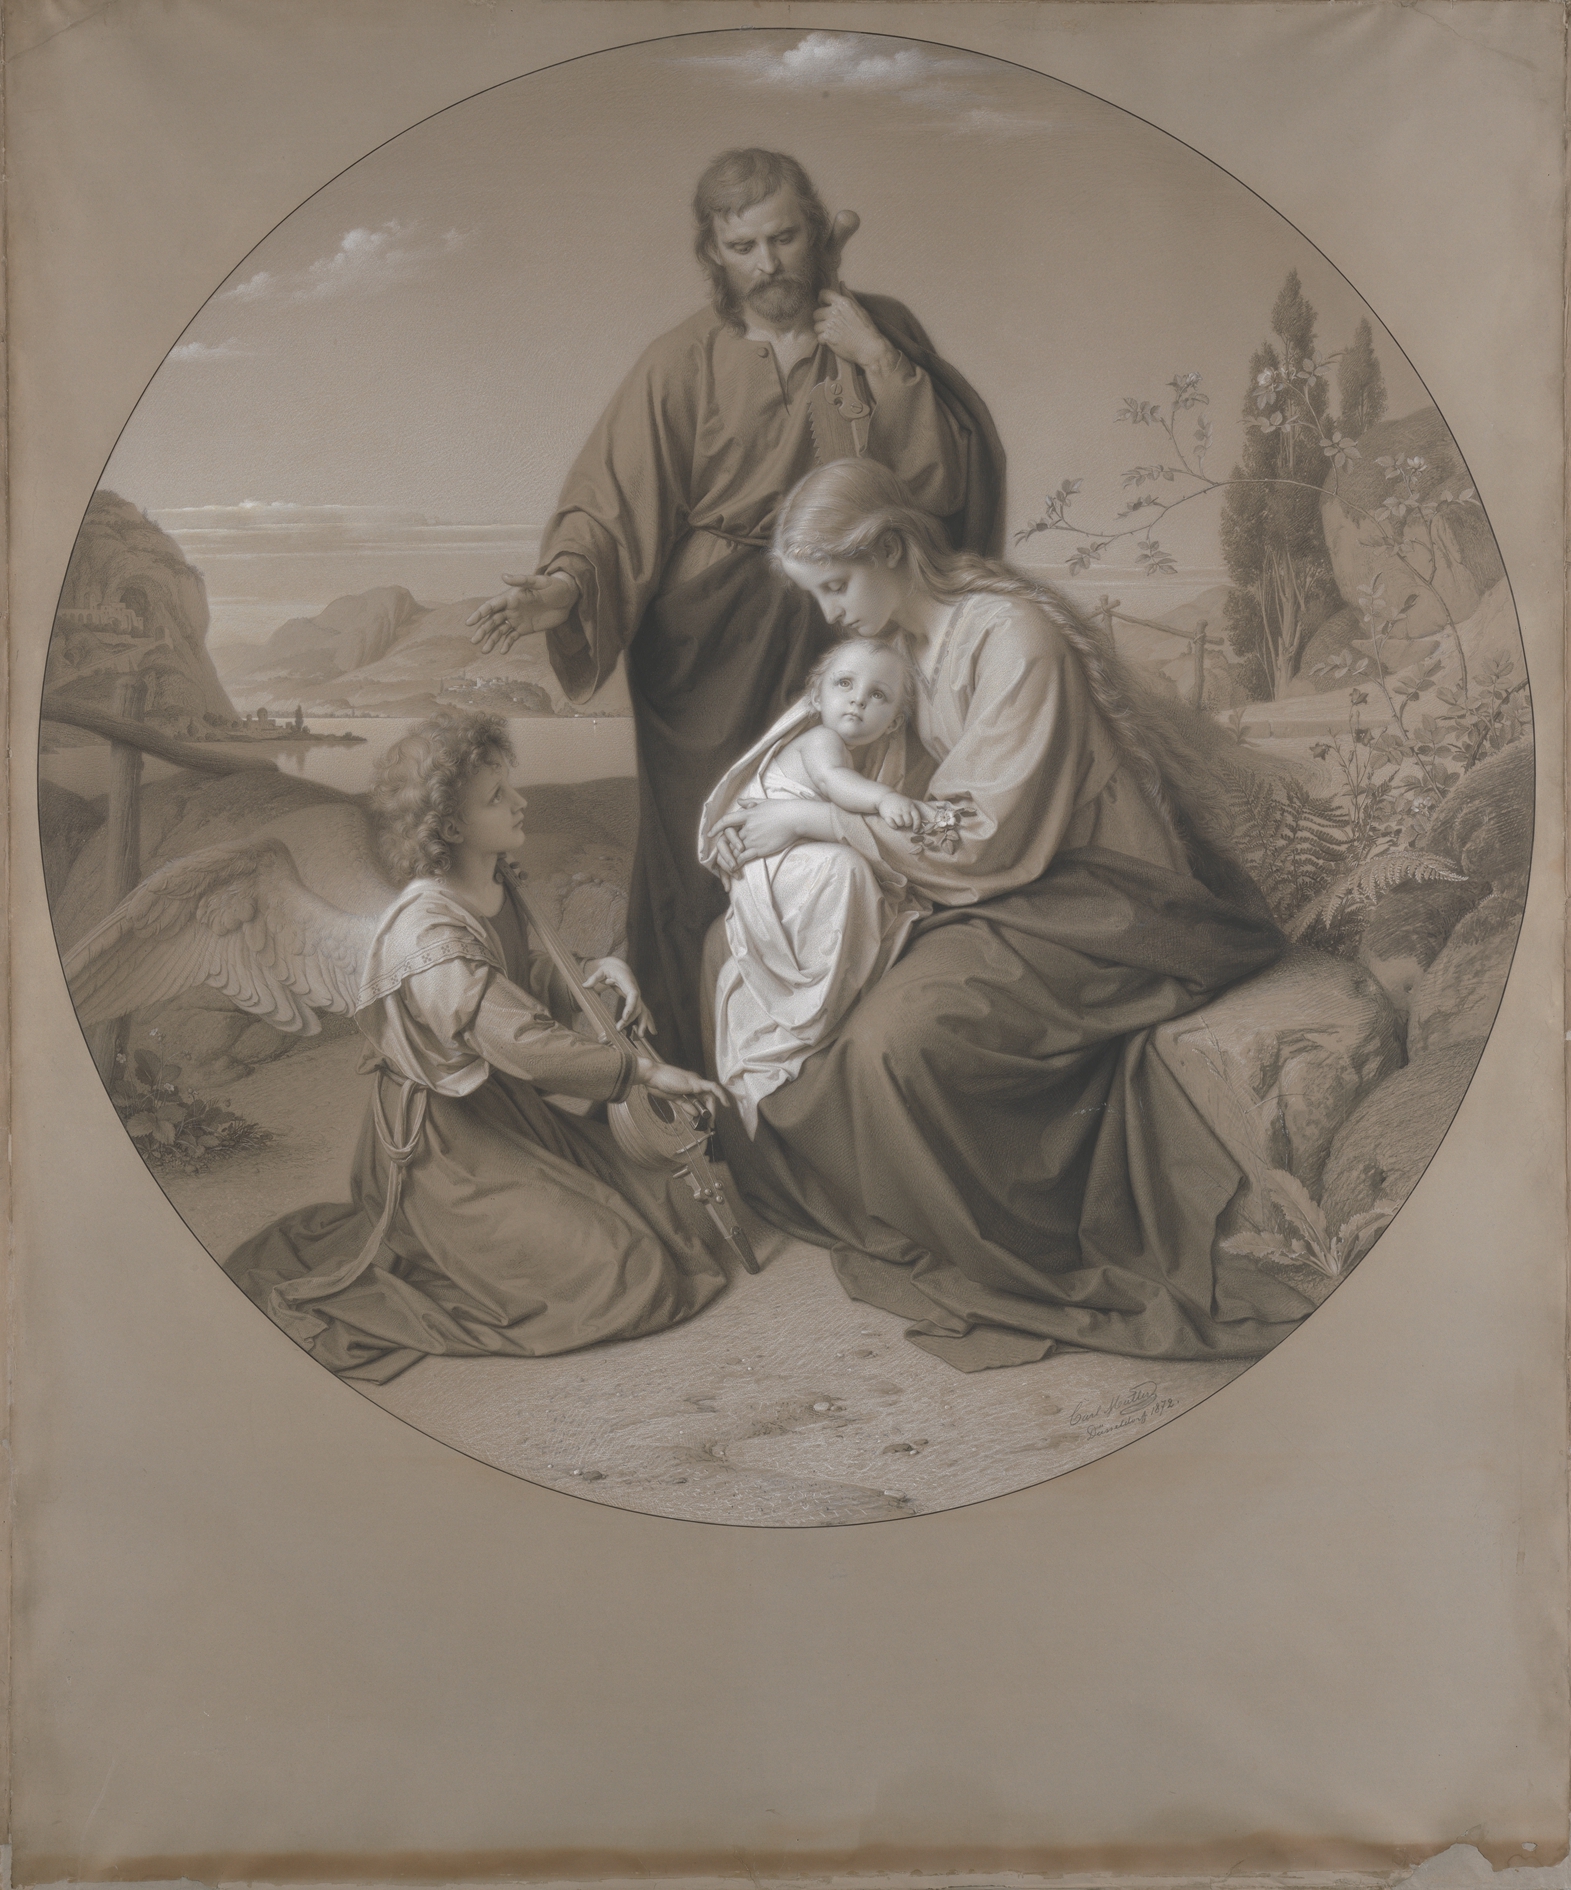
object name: drawing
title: Holy Family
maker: carl müller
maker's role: artist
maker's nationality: german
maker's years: 1818-1893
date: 1872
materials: chalk, paper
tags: infants,men,women,angels,holy family